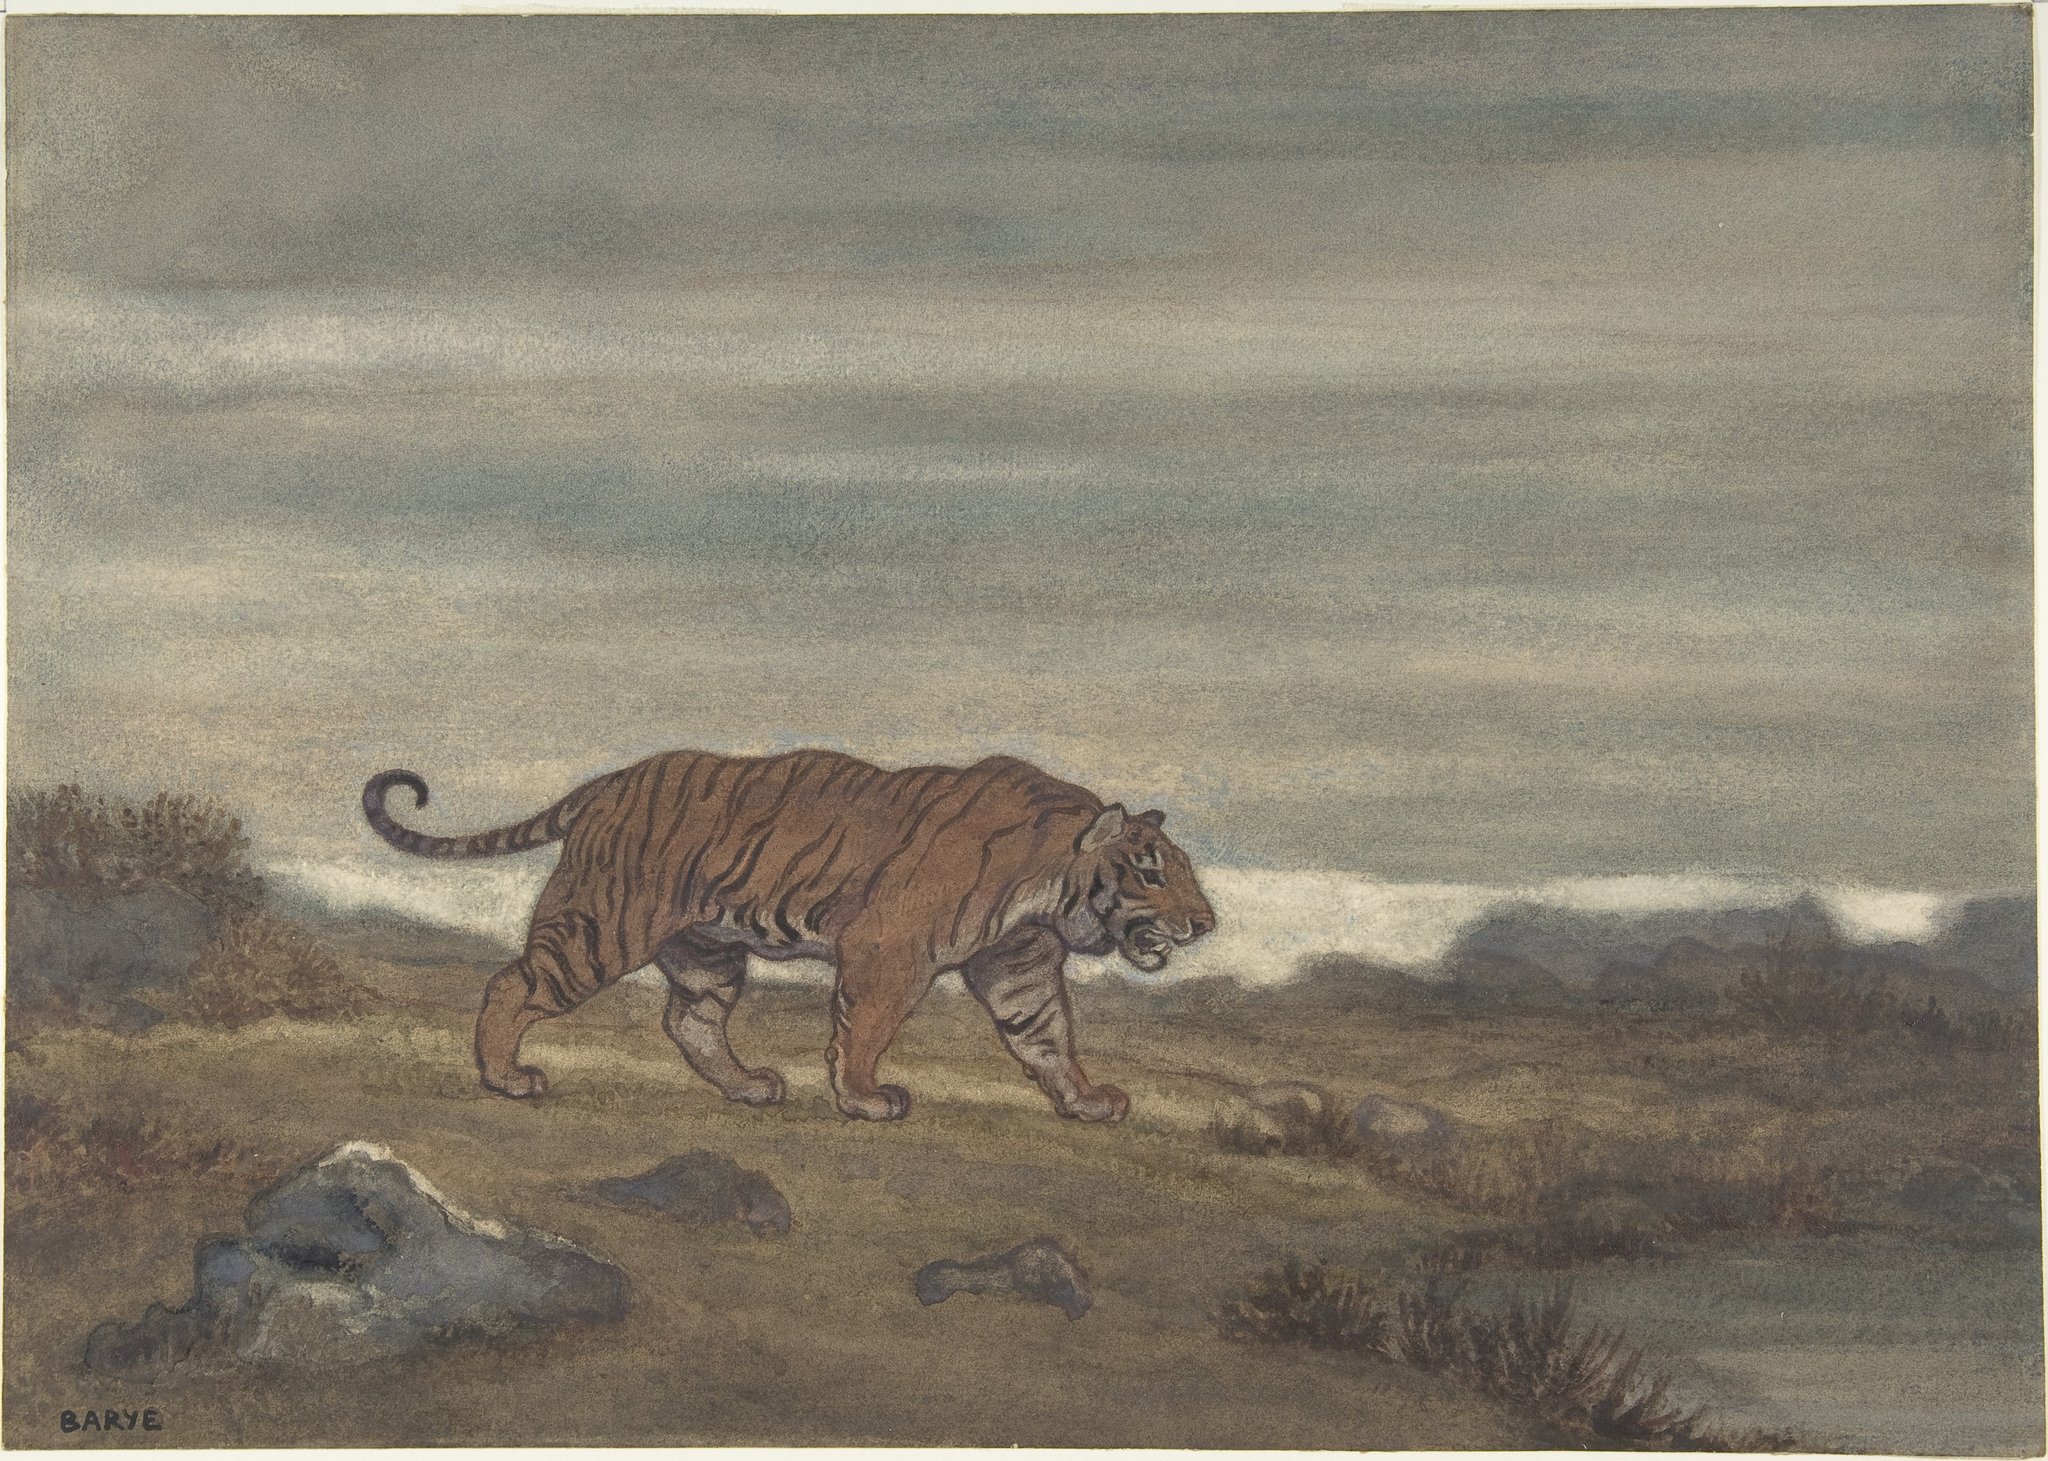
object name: drawing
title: Tiger Approaching Pool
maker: antoine-louis barye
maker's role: artist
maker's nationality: french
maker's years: 1795-1875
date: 1810-1875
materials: watercolor, paper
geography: france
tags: tigers